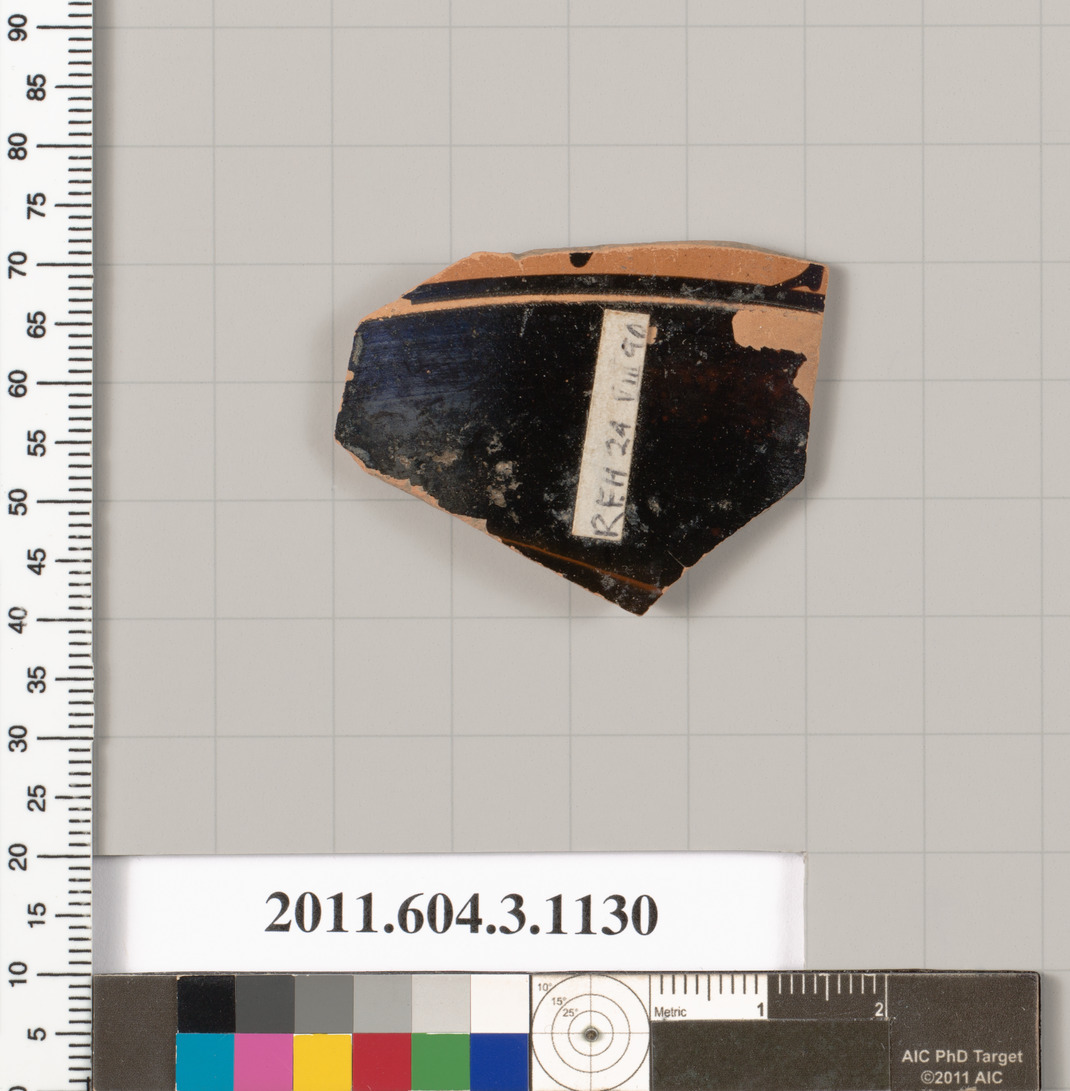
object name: mastoid or kyathos fragment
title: Terracotta fragment of a mastoid (drinking cup with narrow base) or a kyathos (cup-shaped ladle)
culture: greek, attic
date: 534-468 BCE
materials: terracotta